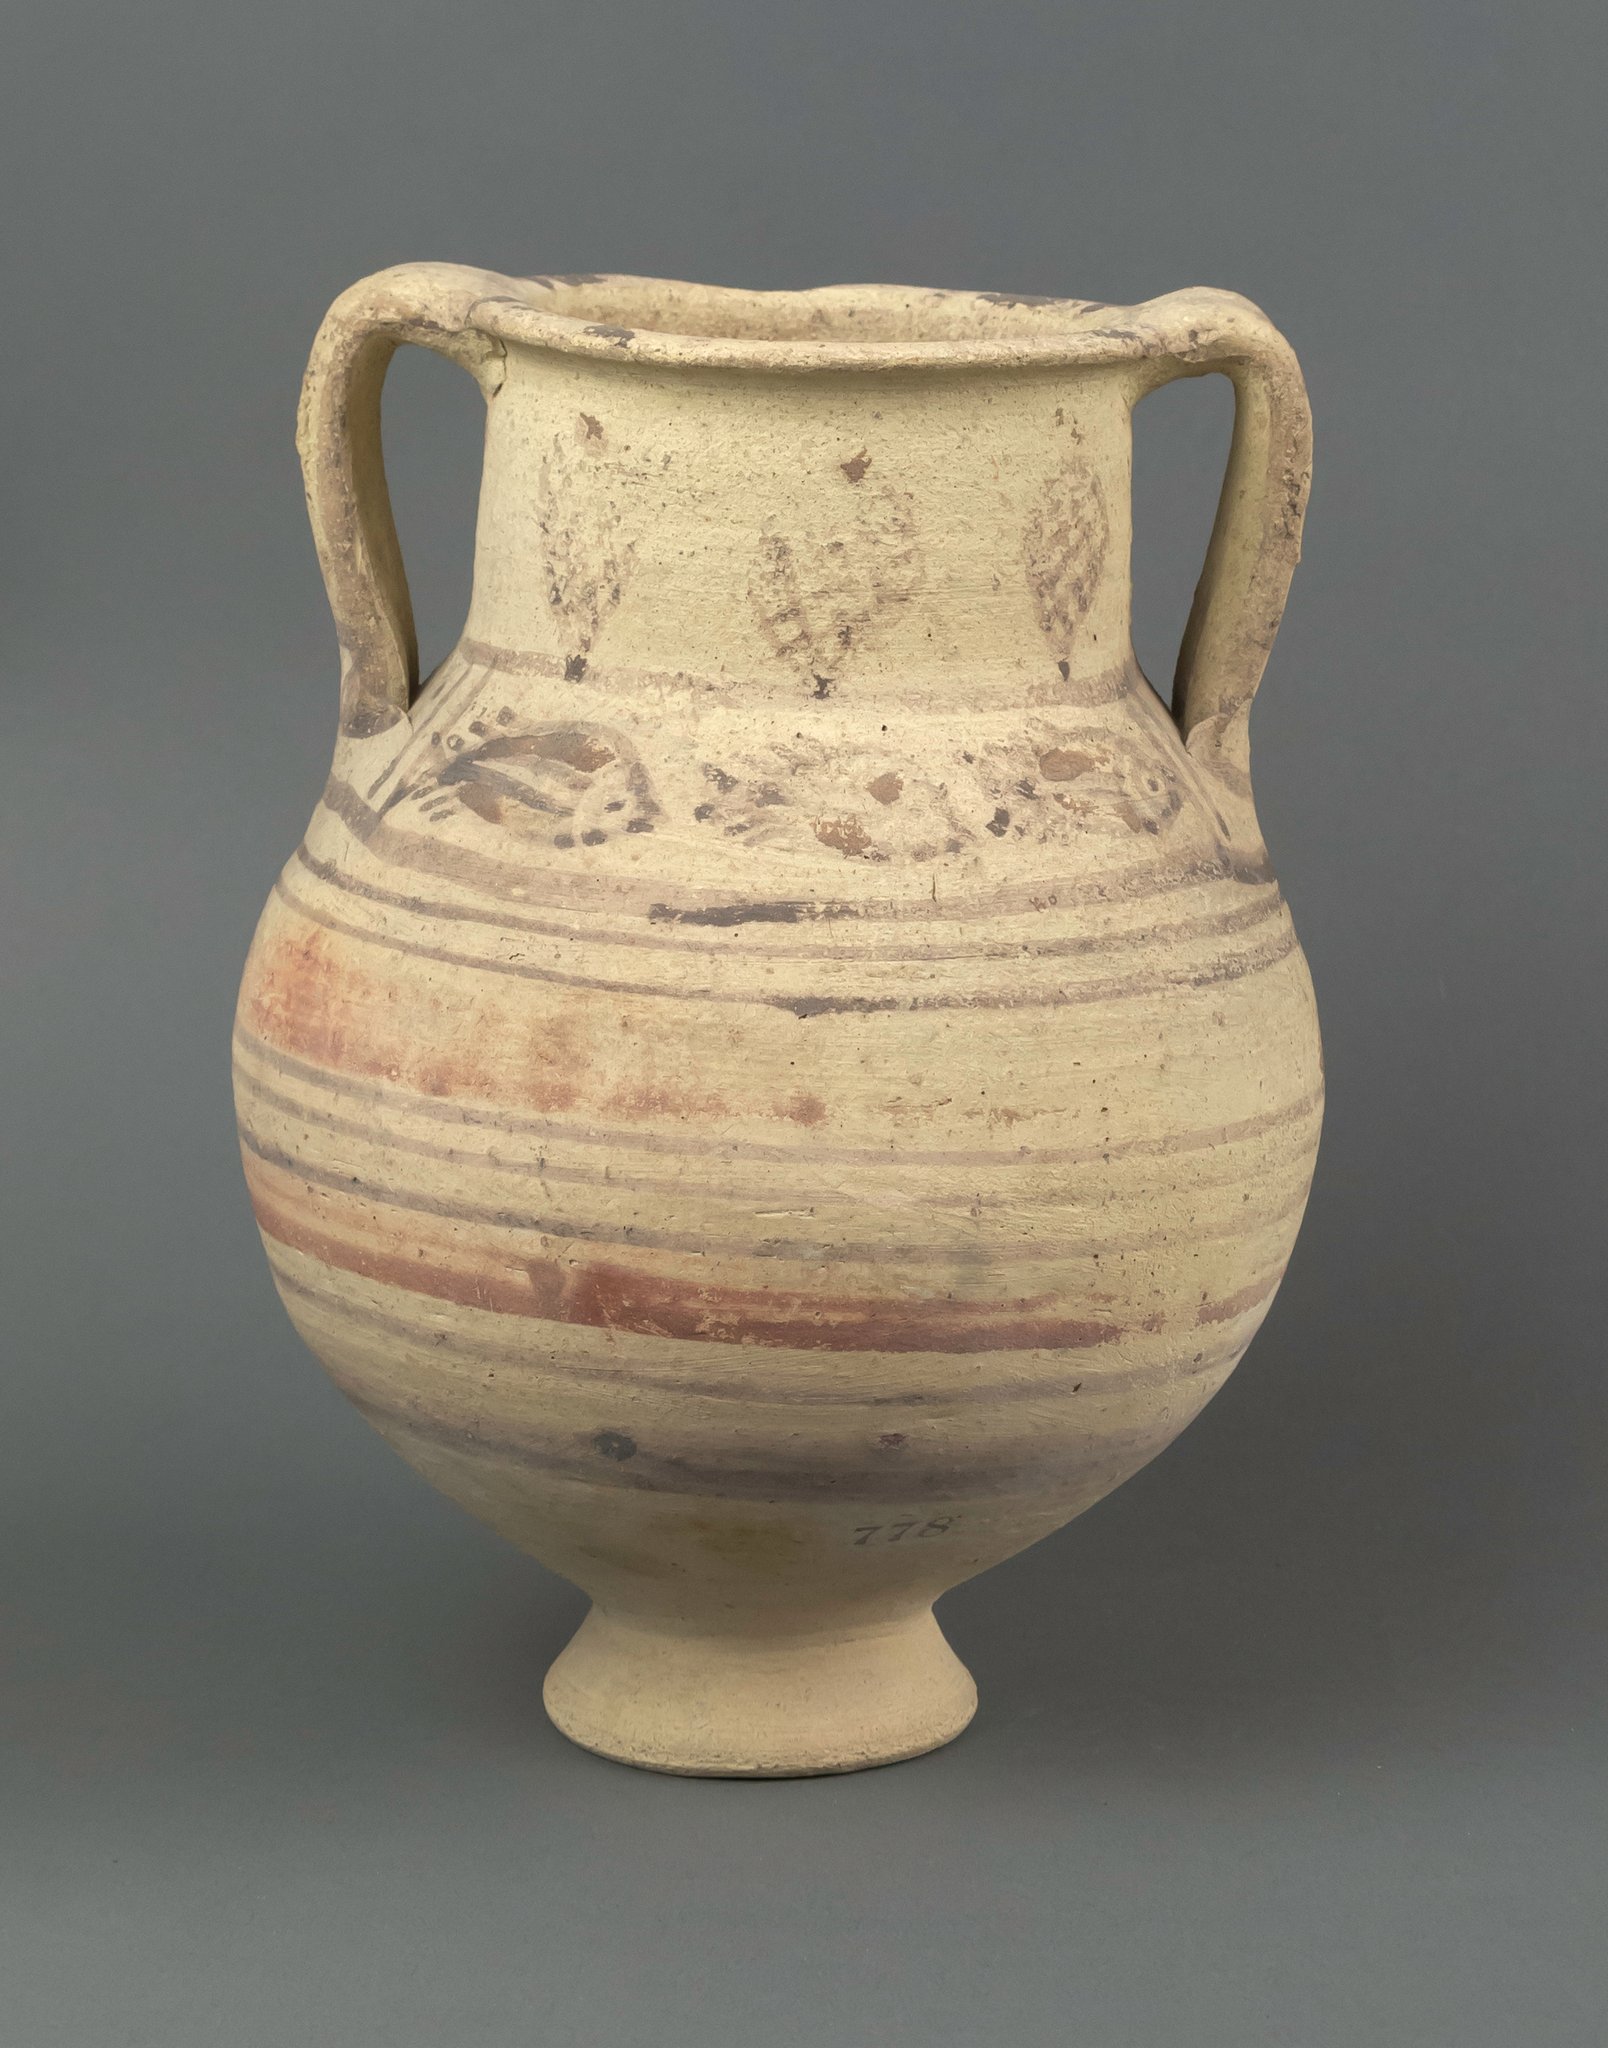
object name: amphora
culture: cypriot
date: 600-480 BCE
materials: terracotta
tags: fish